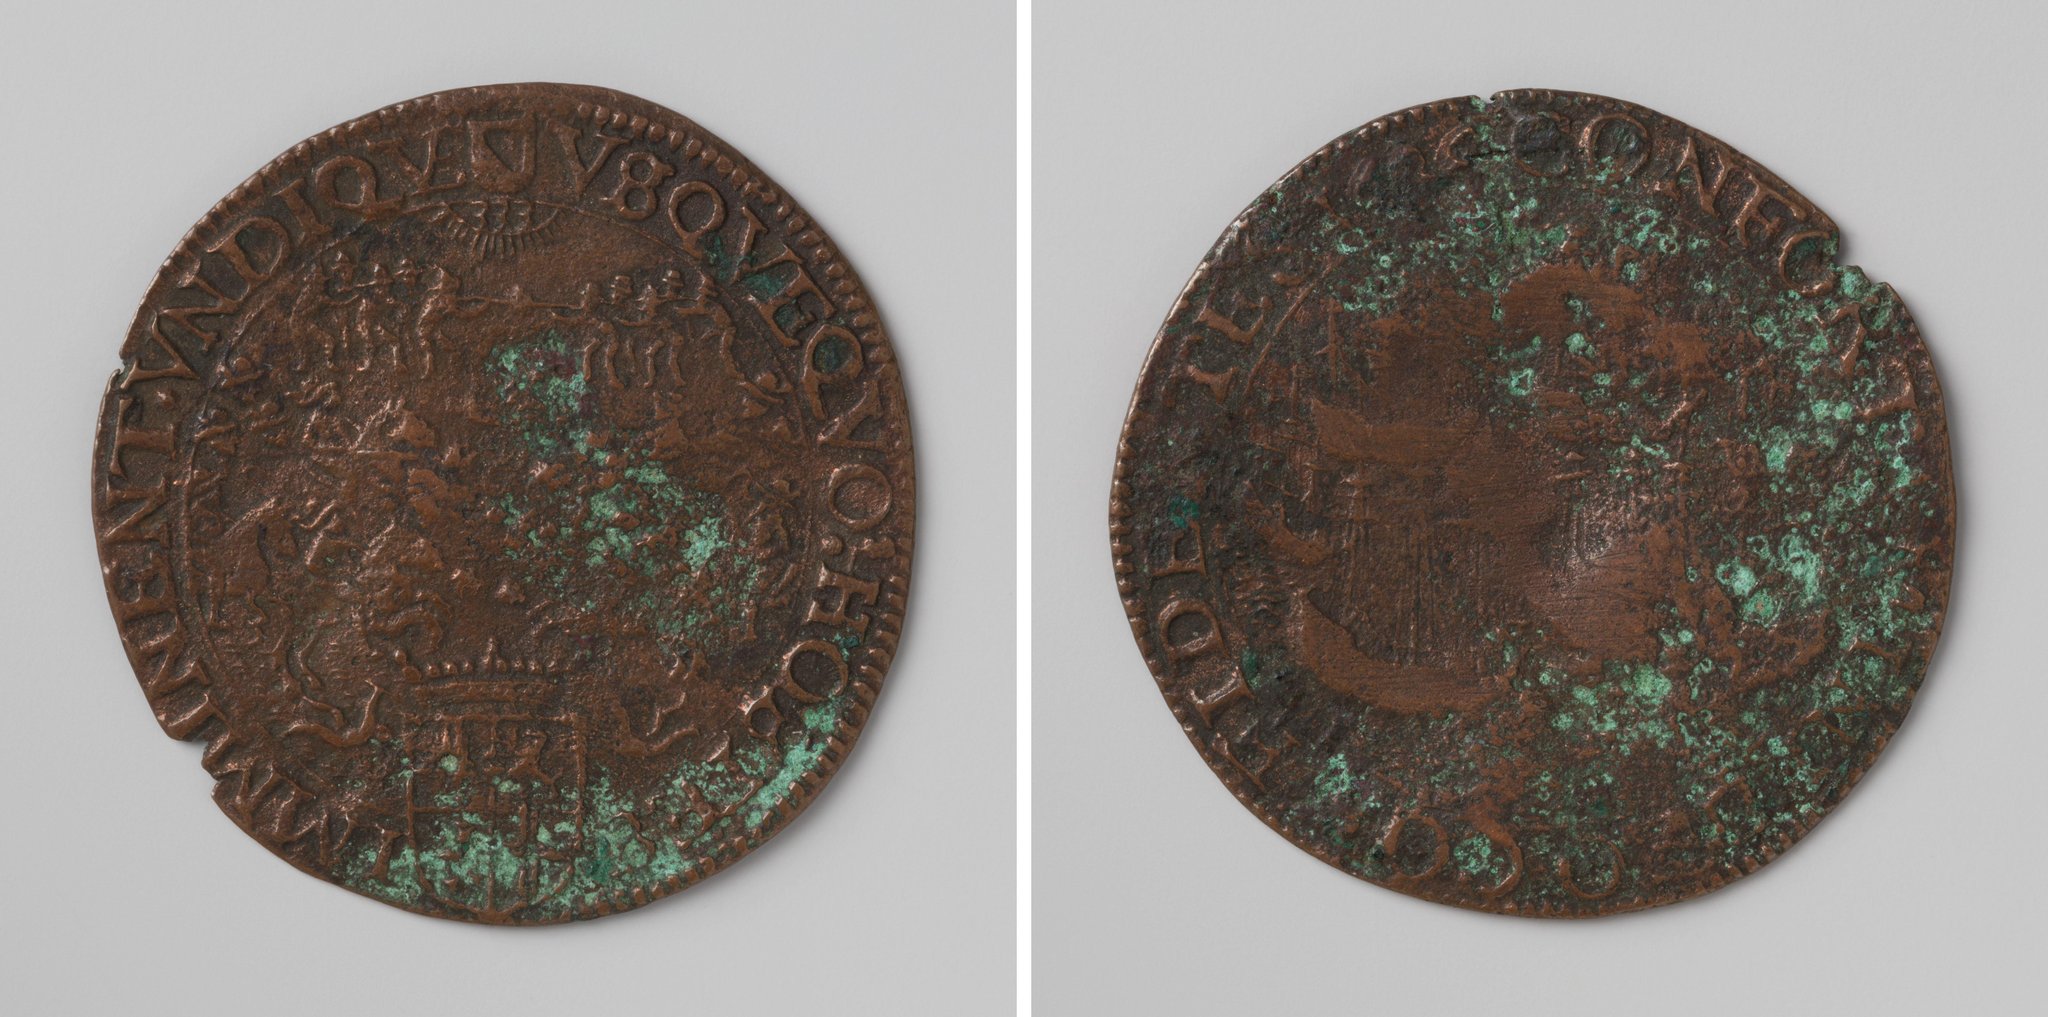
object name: jeton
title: Ongunstig verloop van de strijd tegen Spanje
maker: Anonymous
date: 1626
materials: copper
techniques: striking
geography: utrecht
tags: staten van utrecht, eemland, tachtigjarige oorlog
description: Koperen penning. Voorzijde: gevecht tussen ruiters en soldaten, beschenen door hemellicht met daarin naam jehovah in hebreeuws schrift boven wapenschild binnen omschrift. Keerzijde: schepen op zee met elkaar in gevecht binnen omschrift.